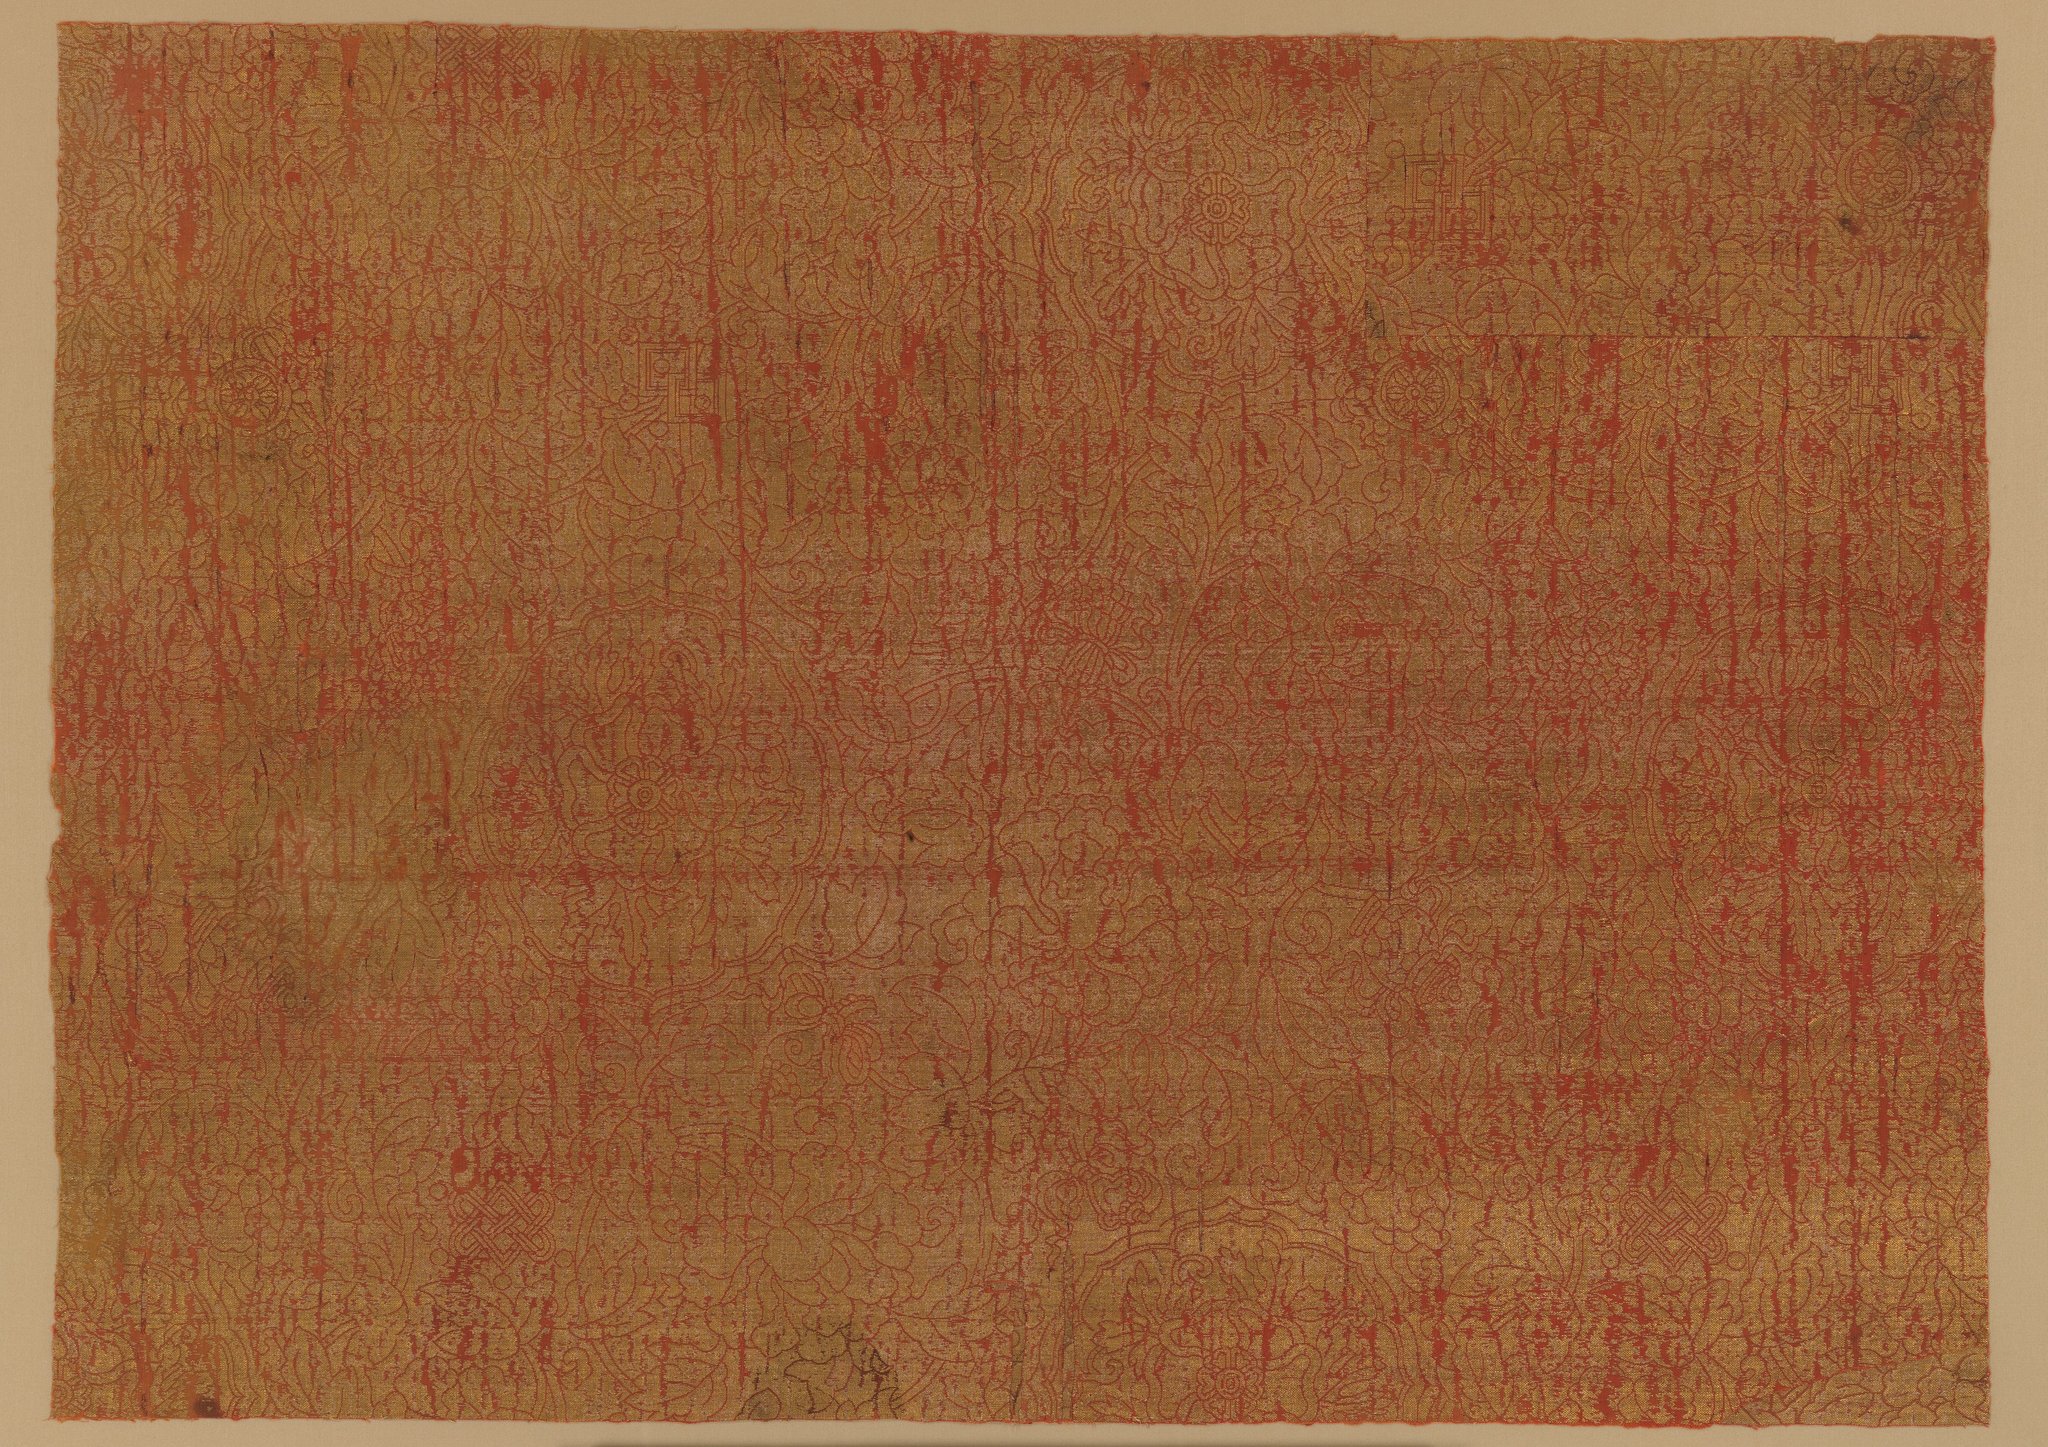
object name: piece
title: "Cloth of Gold" with Medallions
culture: chinese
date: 1301-1400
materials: metal thread, silk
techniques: lampas